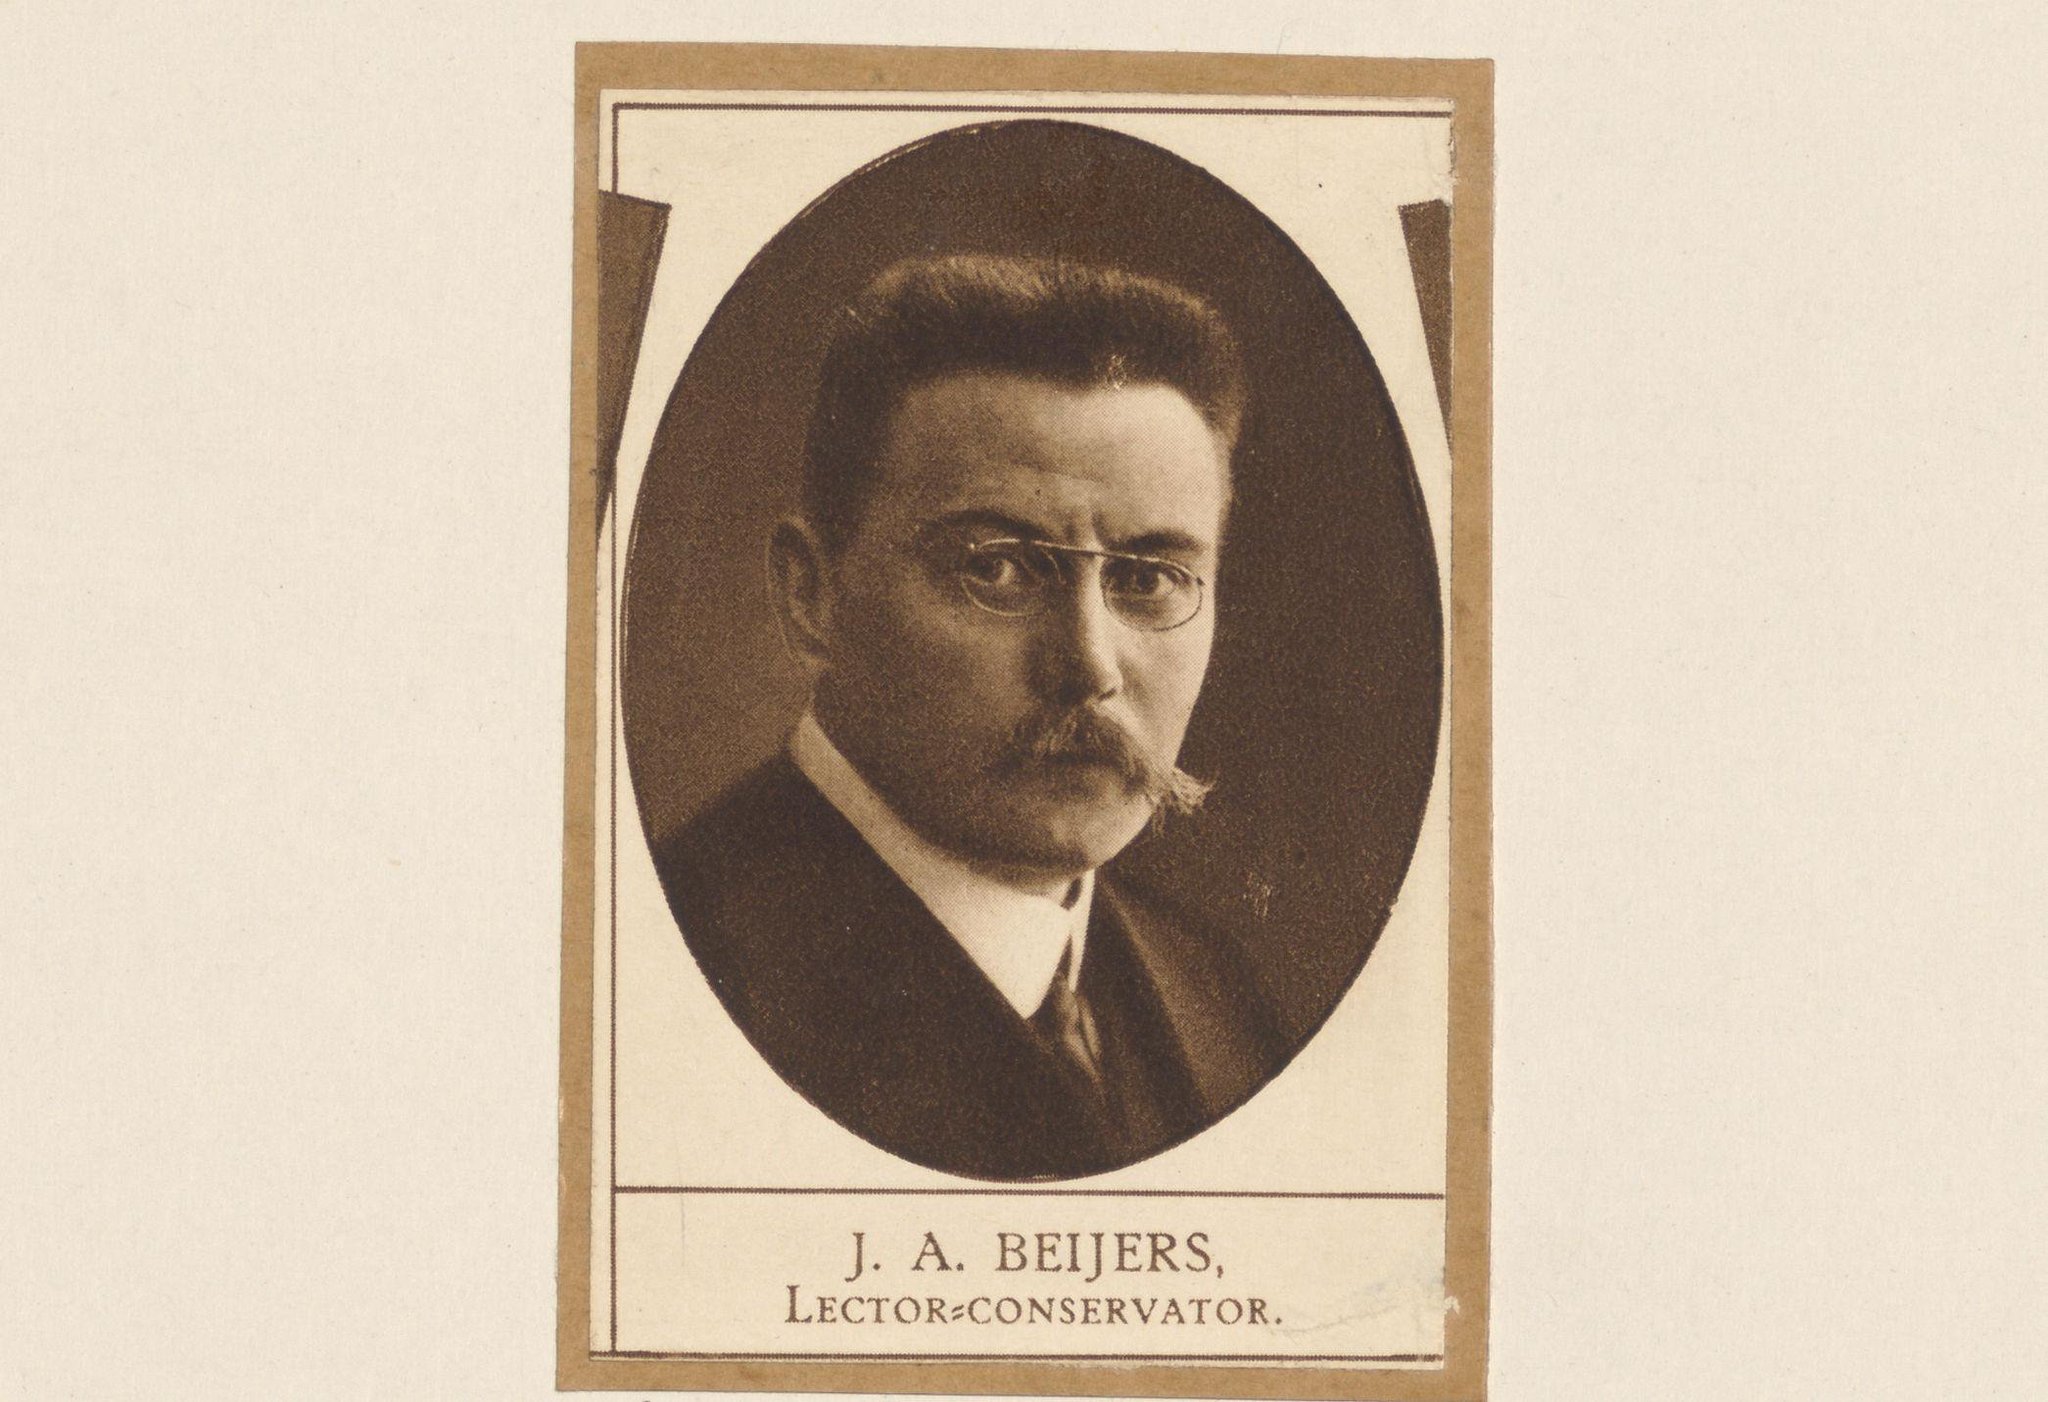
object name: photomechanical print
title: Portret van Johan Albertus Beijers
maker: Anonymous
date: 1918-1949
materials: paper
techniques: rotogravure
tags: eyeglasses, spectacles, historical persons